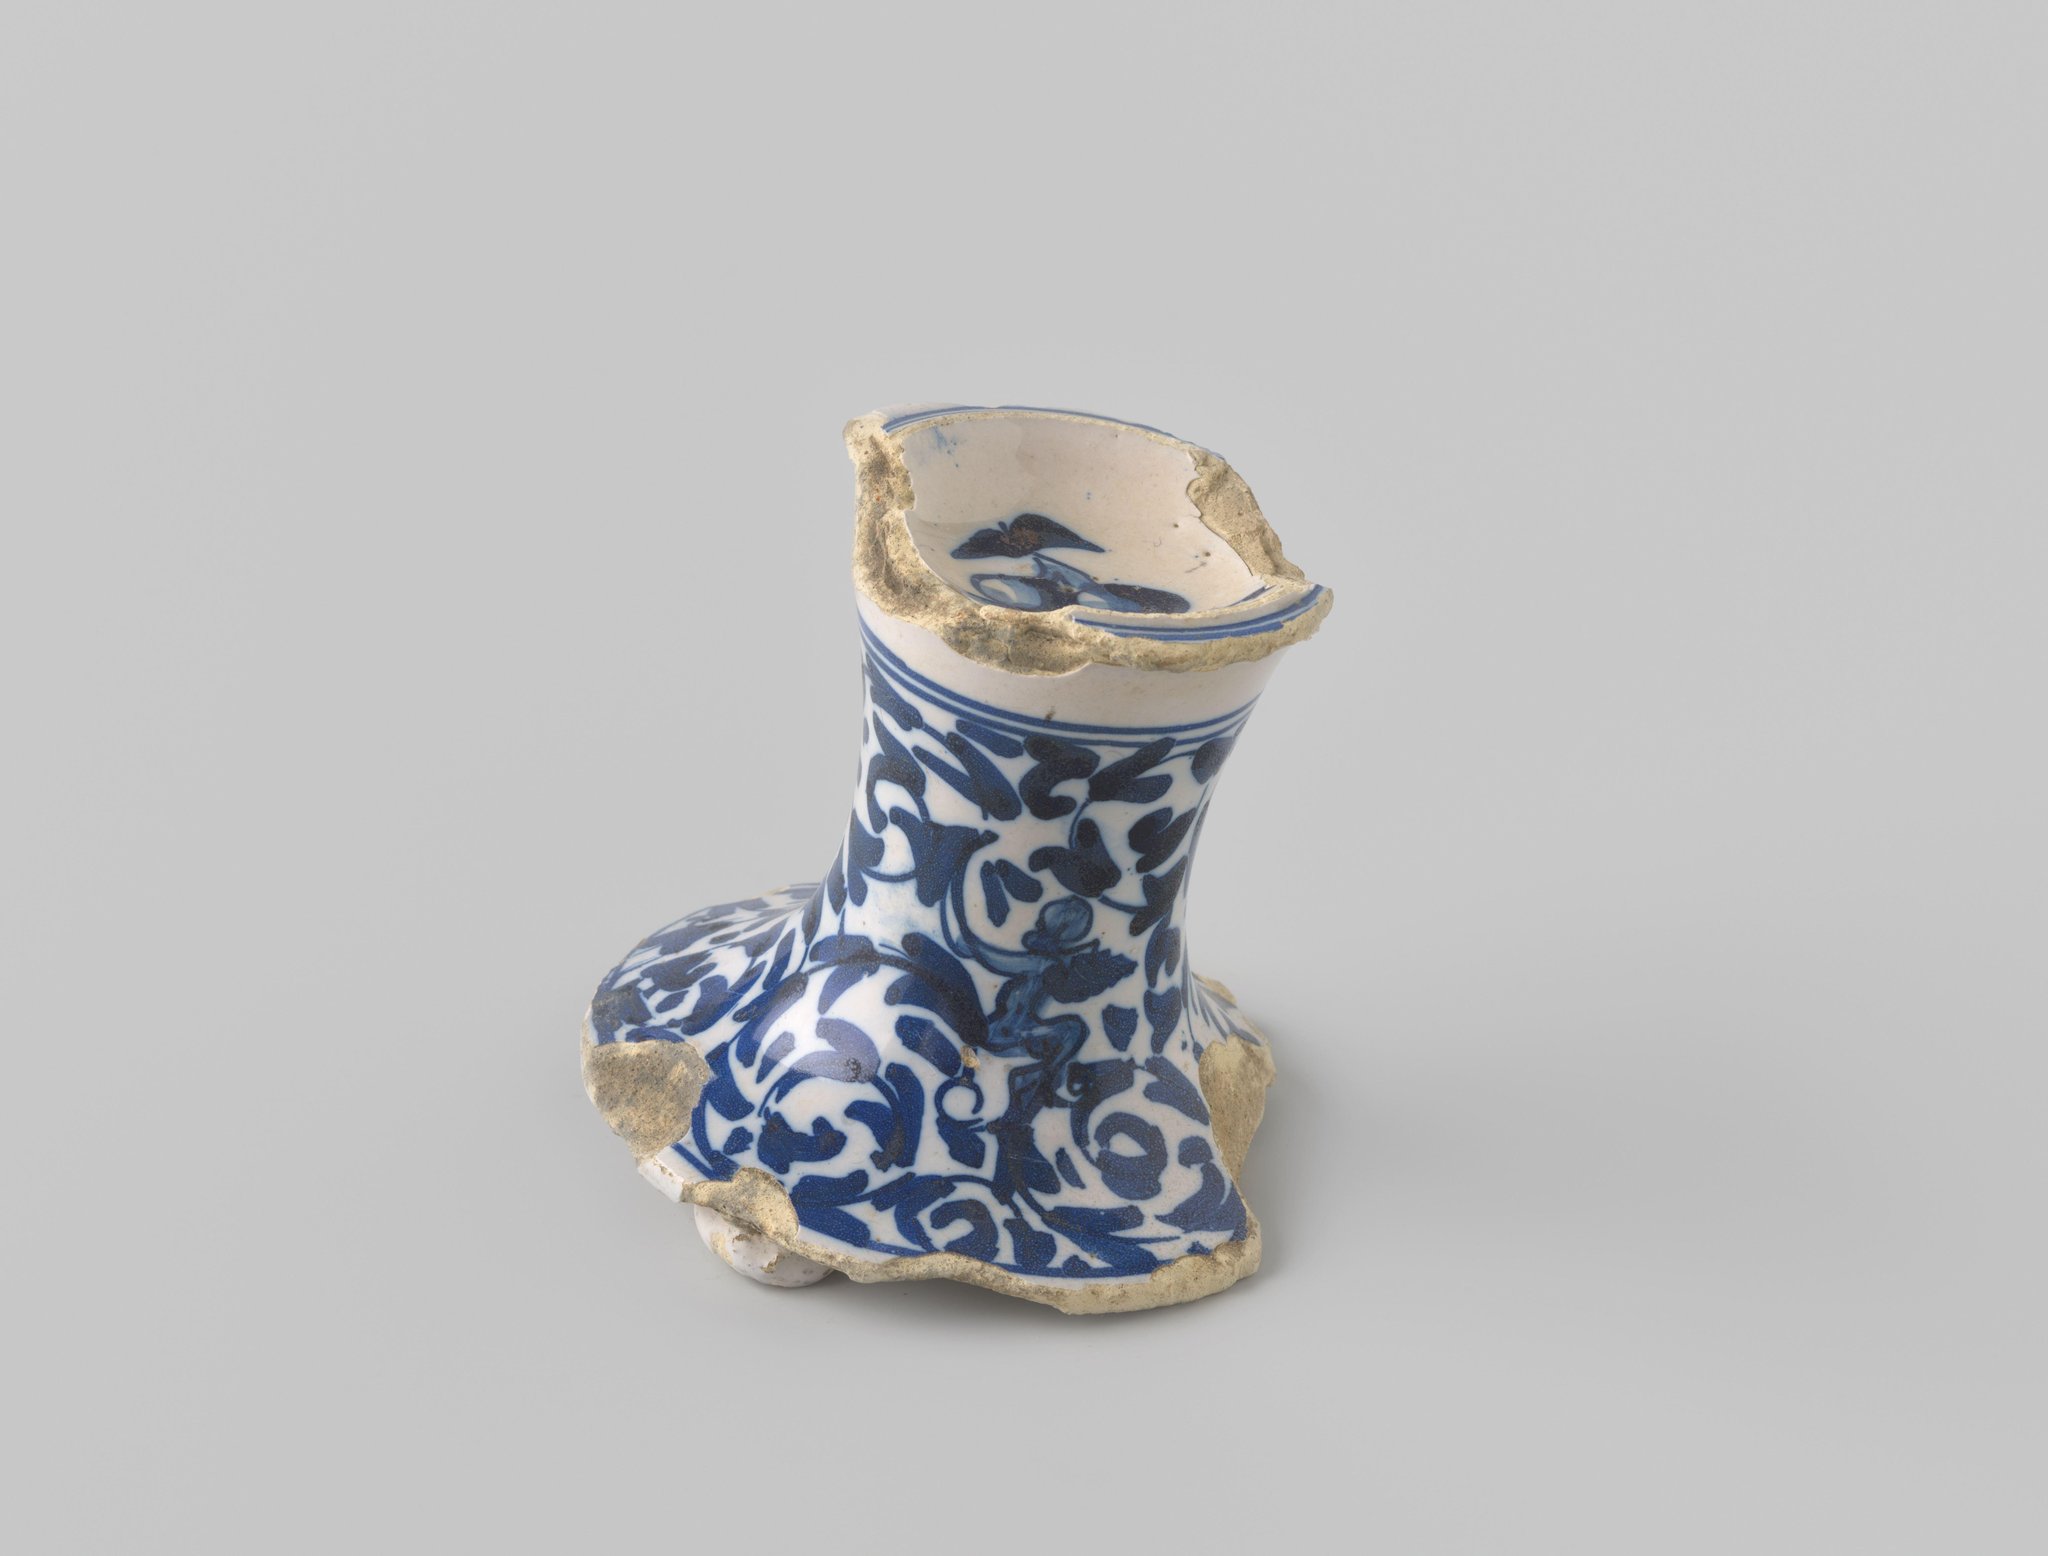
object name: sherd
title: Scherf van witbakkend aardewerk, in de vorm van een vertikale voet gedecoreerd met gestileerde bloemvormen in blauw op een witte ondergrond, en bovenop een plat waarop twee vruchten in blauw op wit zijn geschilderd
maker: Anonymous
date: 1500-1699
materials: earthenware, glaze